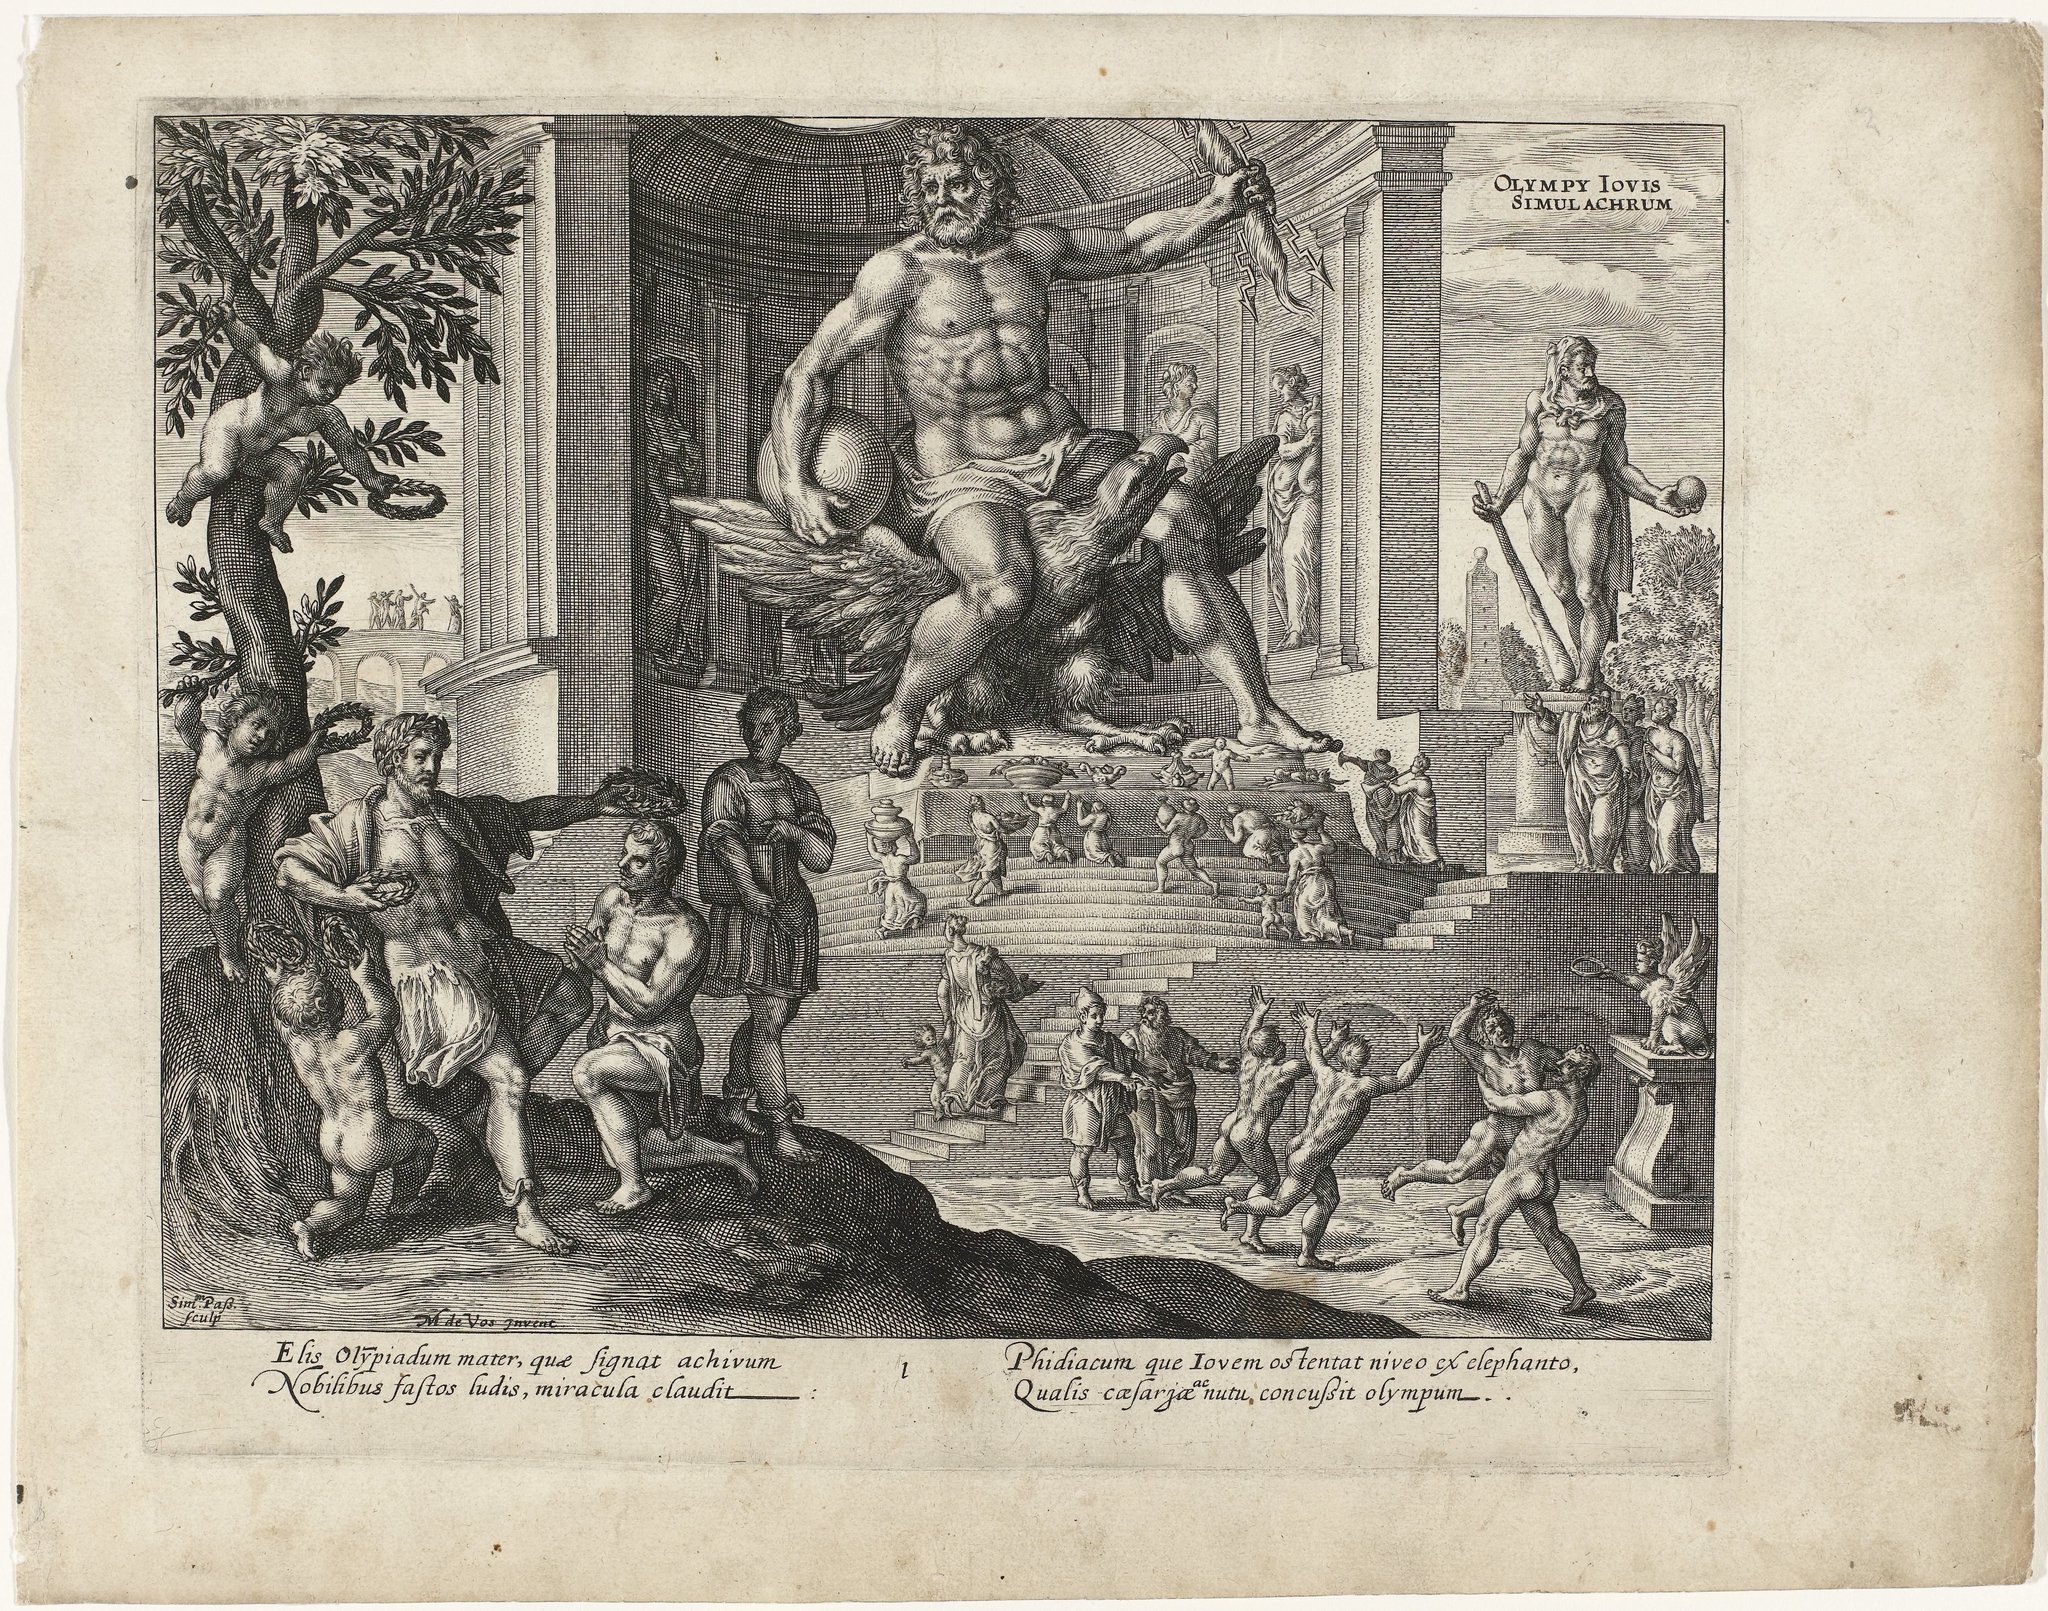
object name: print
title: De zeven wereldwonderen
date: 1614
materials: paper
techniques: engraving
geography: utrecht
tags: statue of zeus by phidias (wonder of the world)